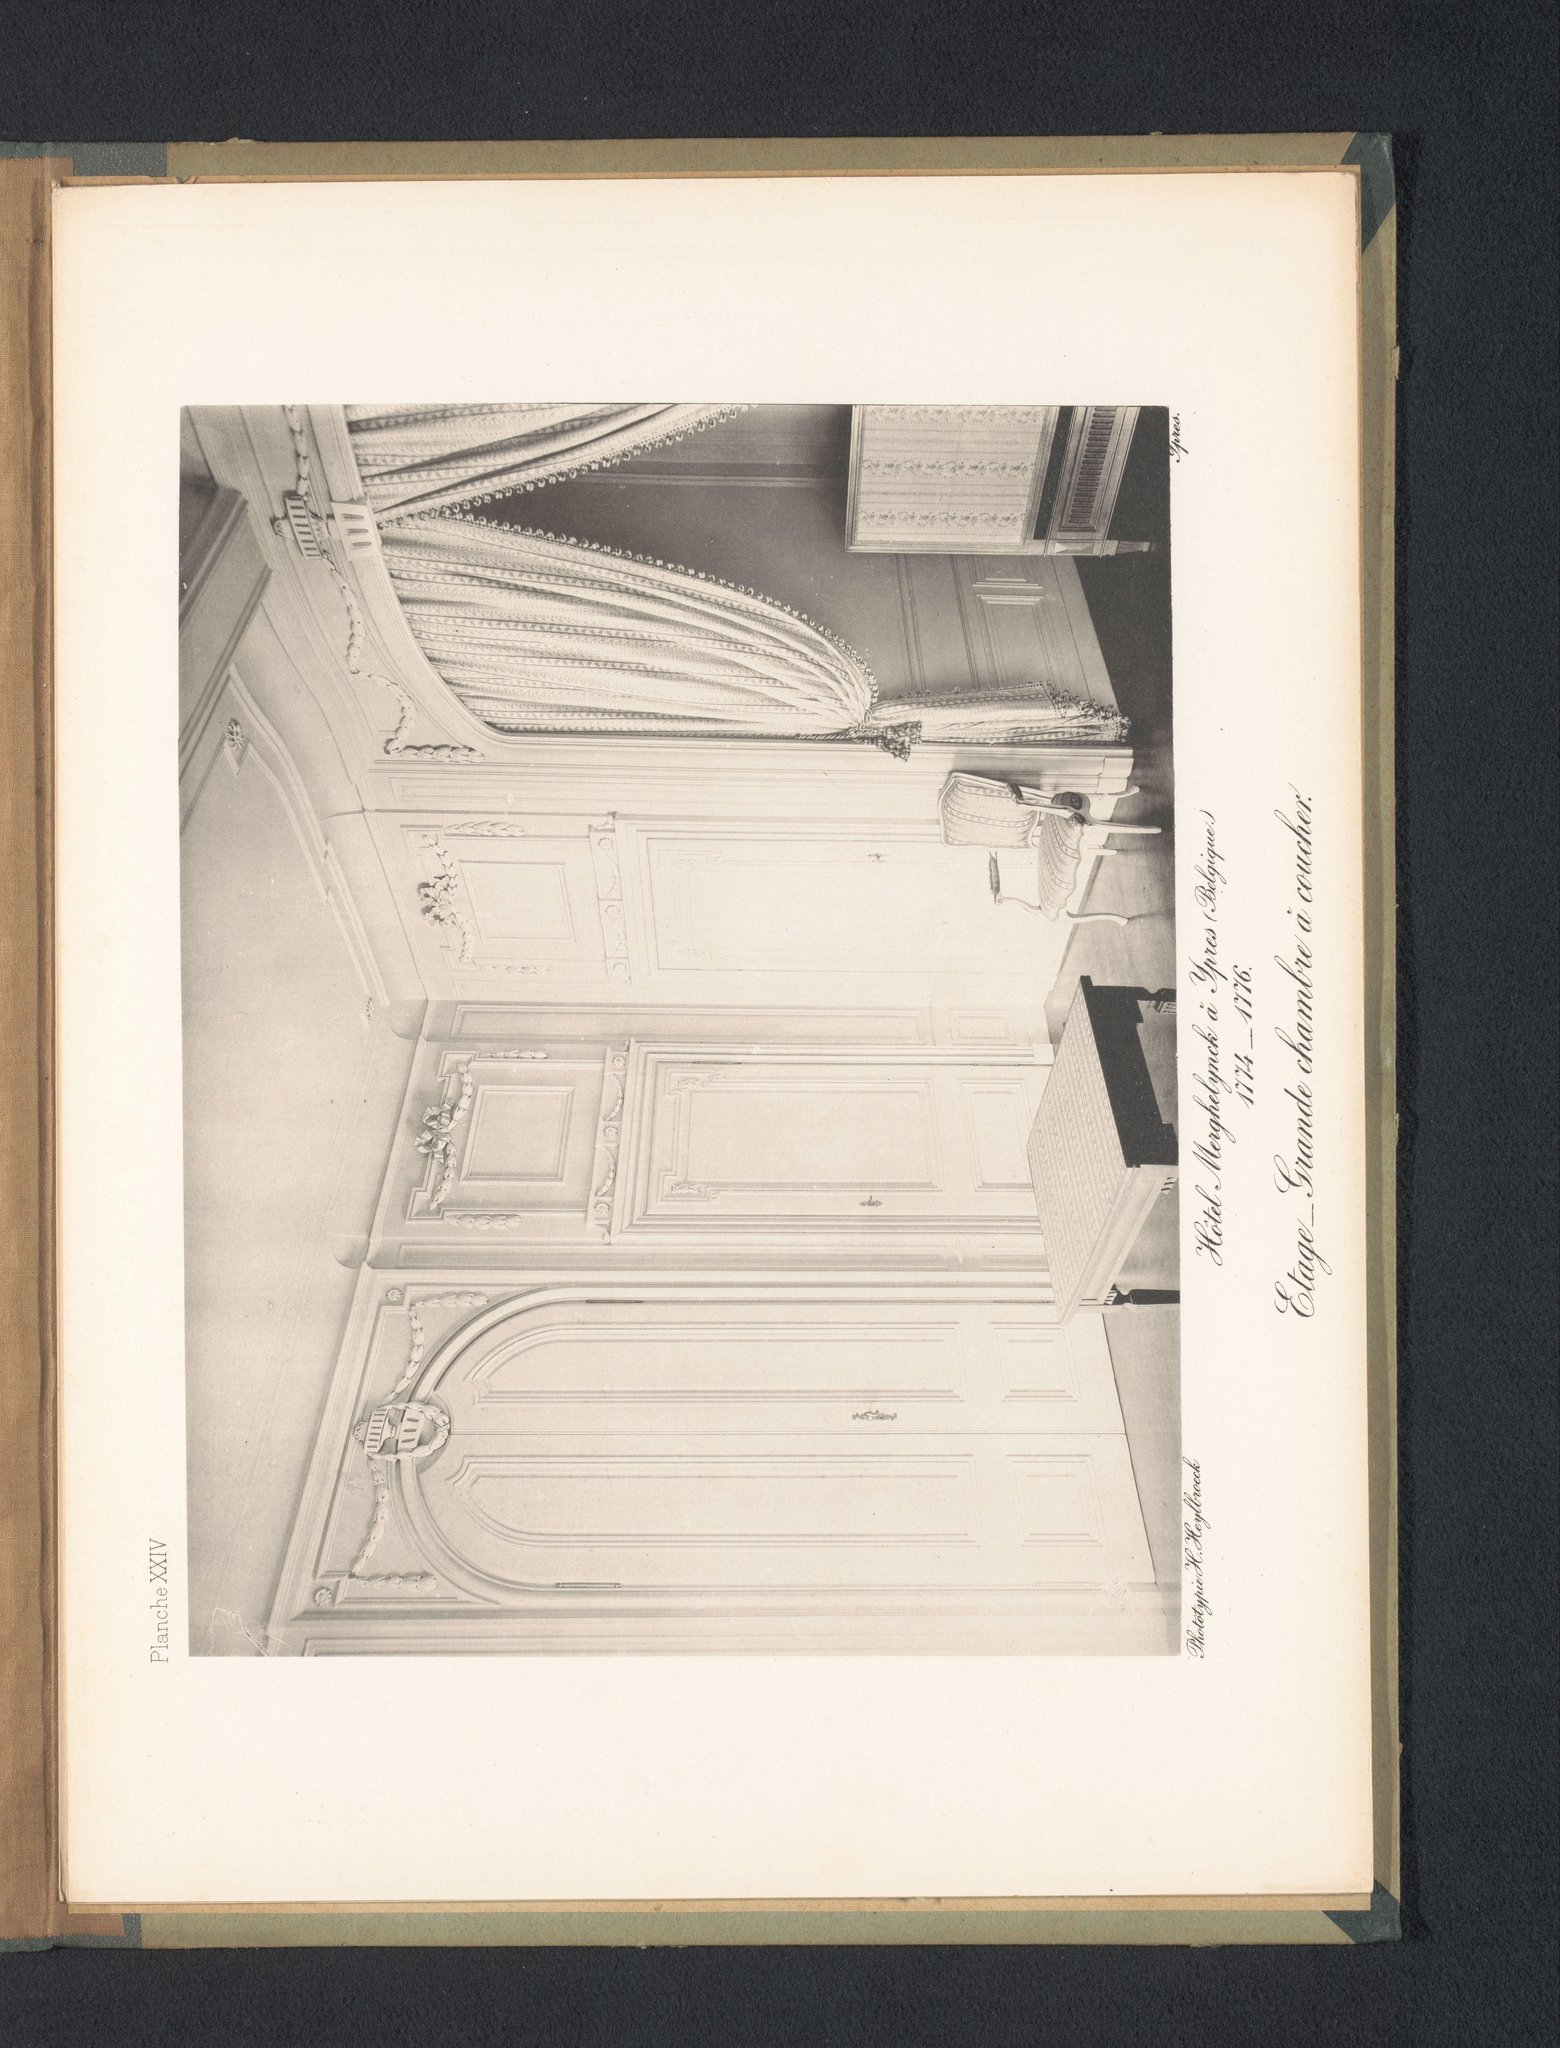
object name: photomechanical print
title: Hôtel Merghelynck à Ypres (Belgique) 1774-1776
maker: hector heylbroeck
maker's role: fotograaf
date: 1889-1894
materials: paper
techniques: photograph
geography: ieper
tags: hotel, hostelry, inn, bedroom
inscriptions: number: ‘Planche XXIV’, inscription: ‘Ypres.’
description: Deze prent maakt deel uit van een omslag met 31 prenten en een katern met teksten.